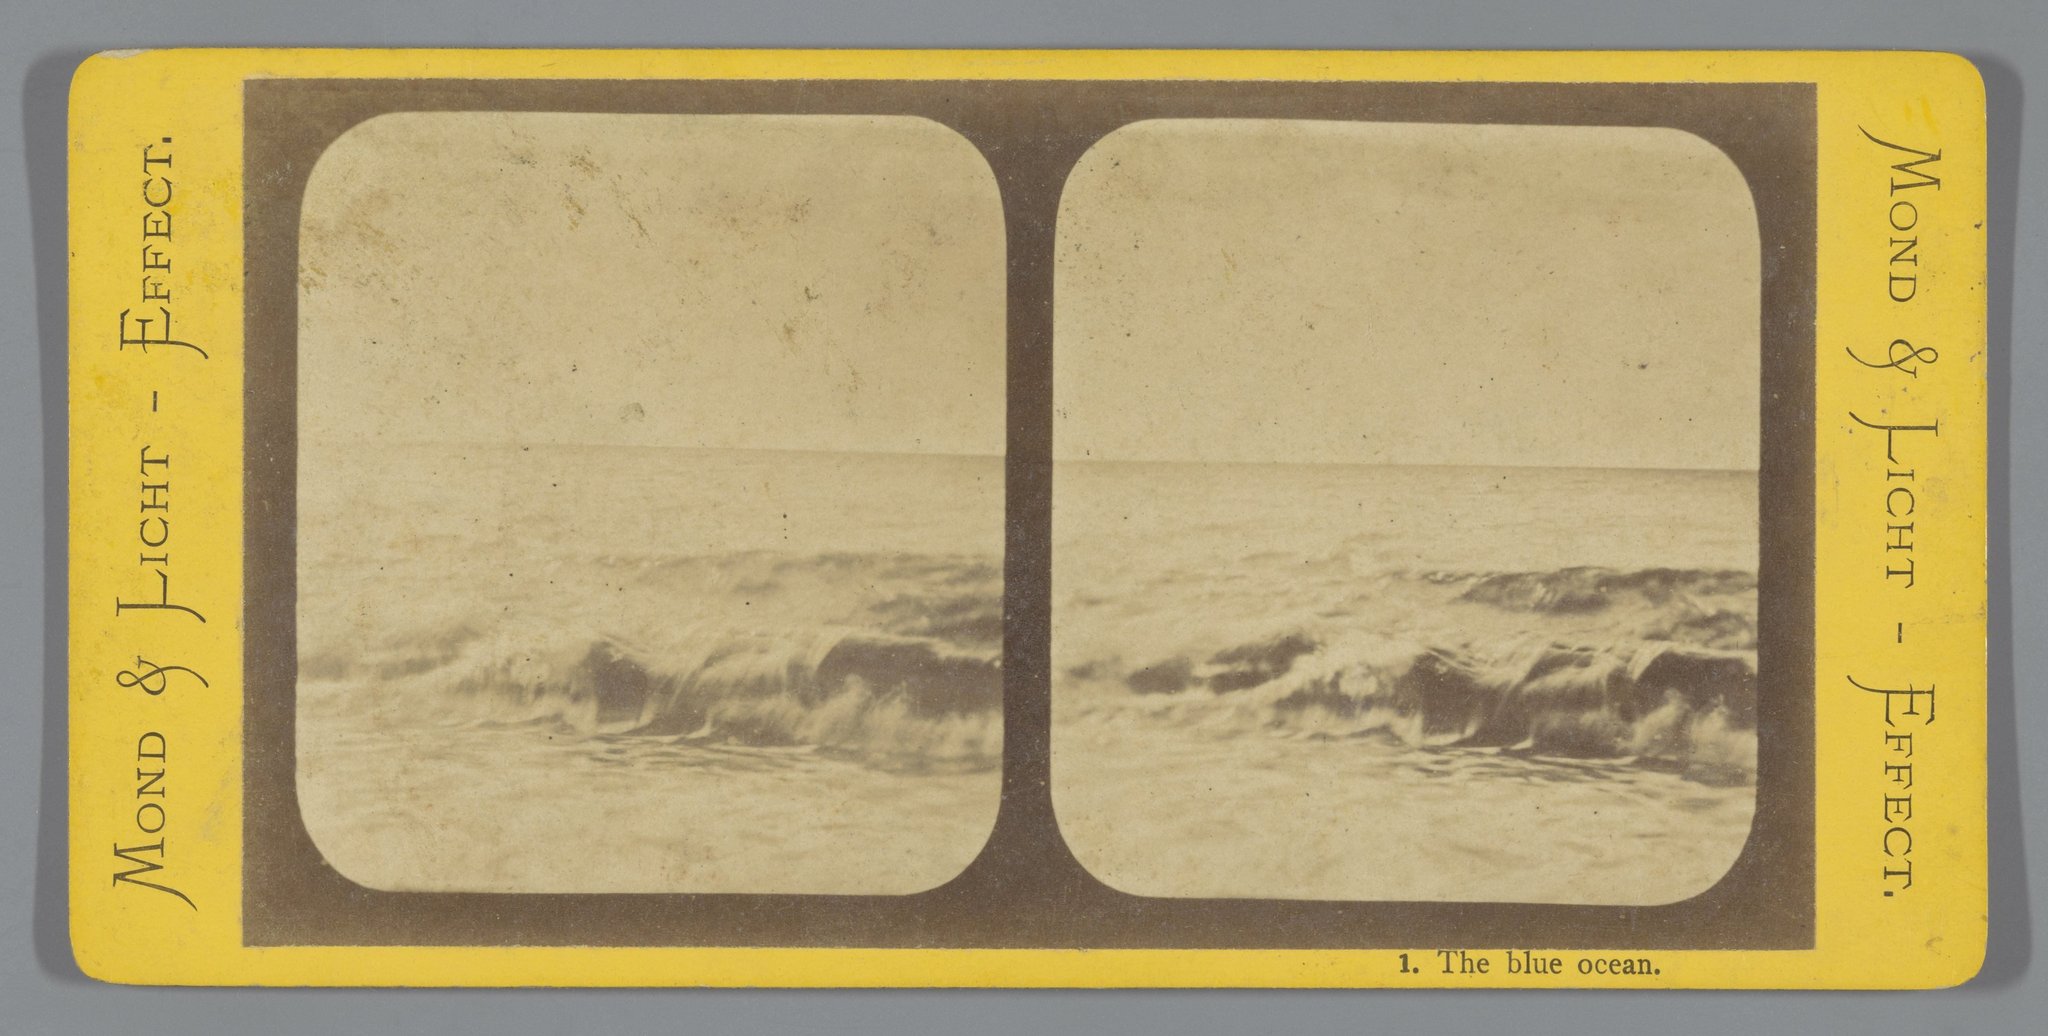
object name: stereograph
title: Mond & Licht-Effect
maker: Anonymous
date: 1868-1890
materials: cardboard, paper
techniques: albumen print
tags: ocean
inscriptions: number: ‘60’, number: ‘1’